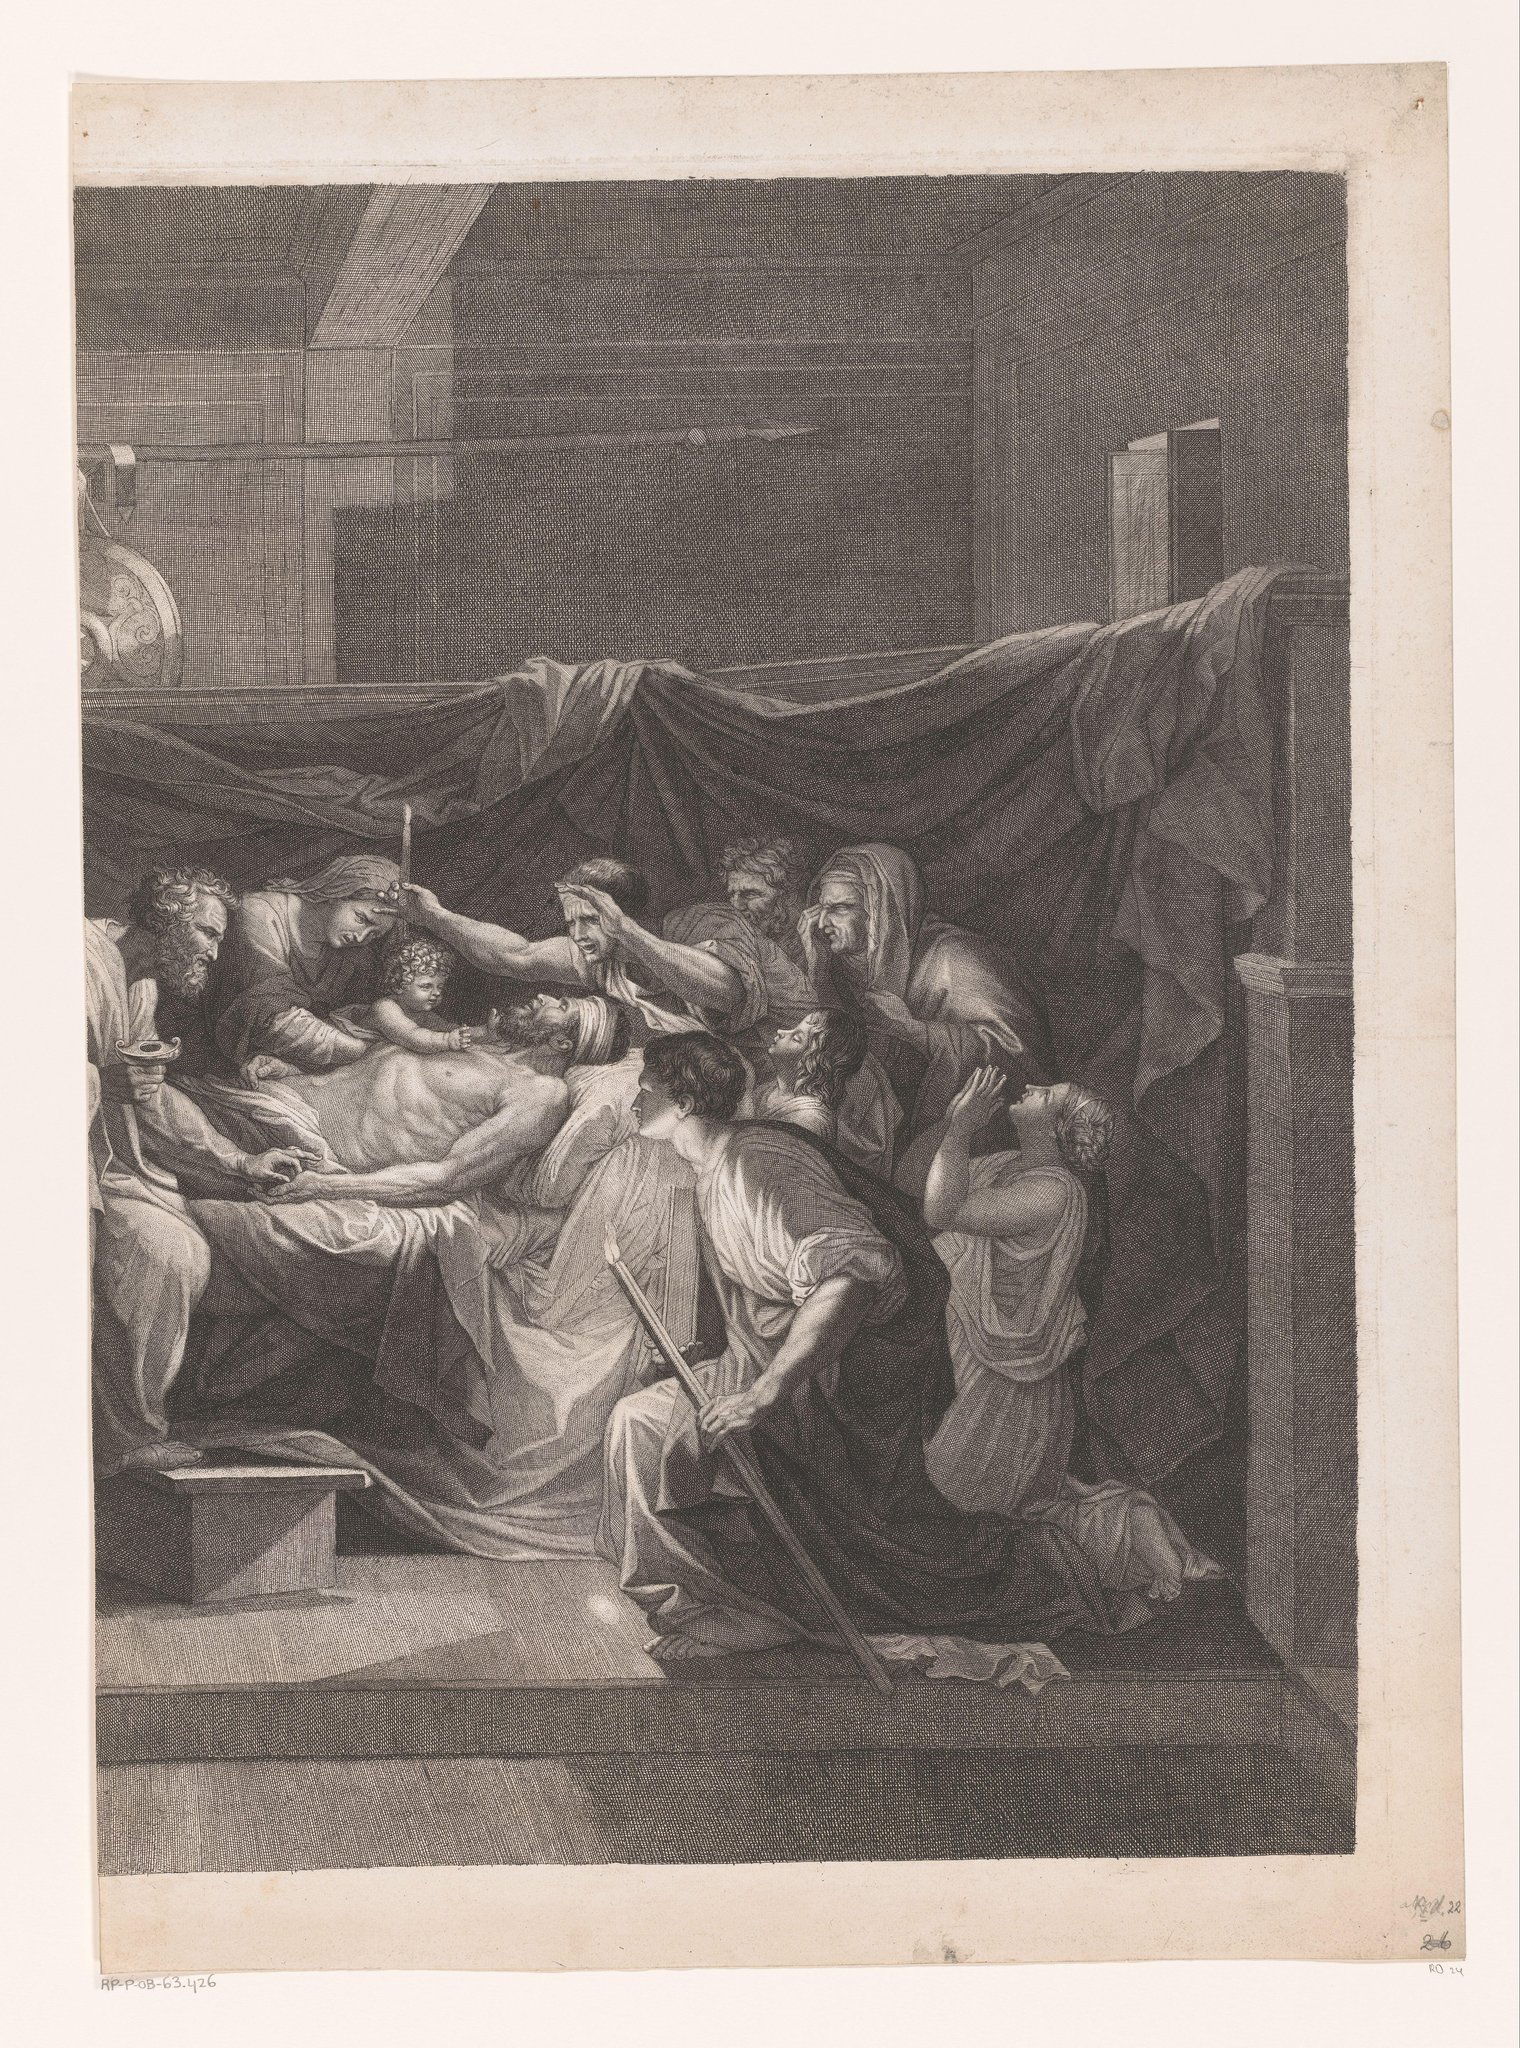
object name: print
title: Zeven sacramenten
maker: jean pesne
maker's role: print maker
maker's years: 1623-1700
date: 1633-1700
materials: paper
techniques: etching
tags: extreme unction ~ the last of the seven sacraments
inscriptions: collector's mark: Lugt 240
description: Prent maakt deel uit van een ongenummerde serie van zeven prenten.